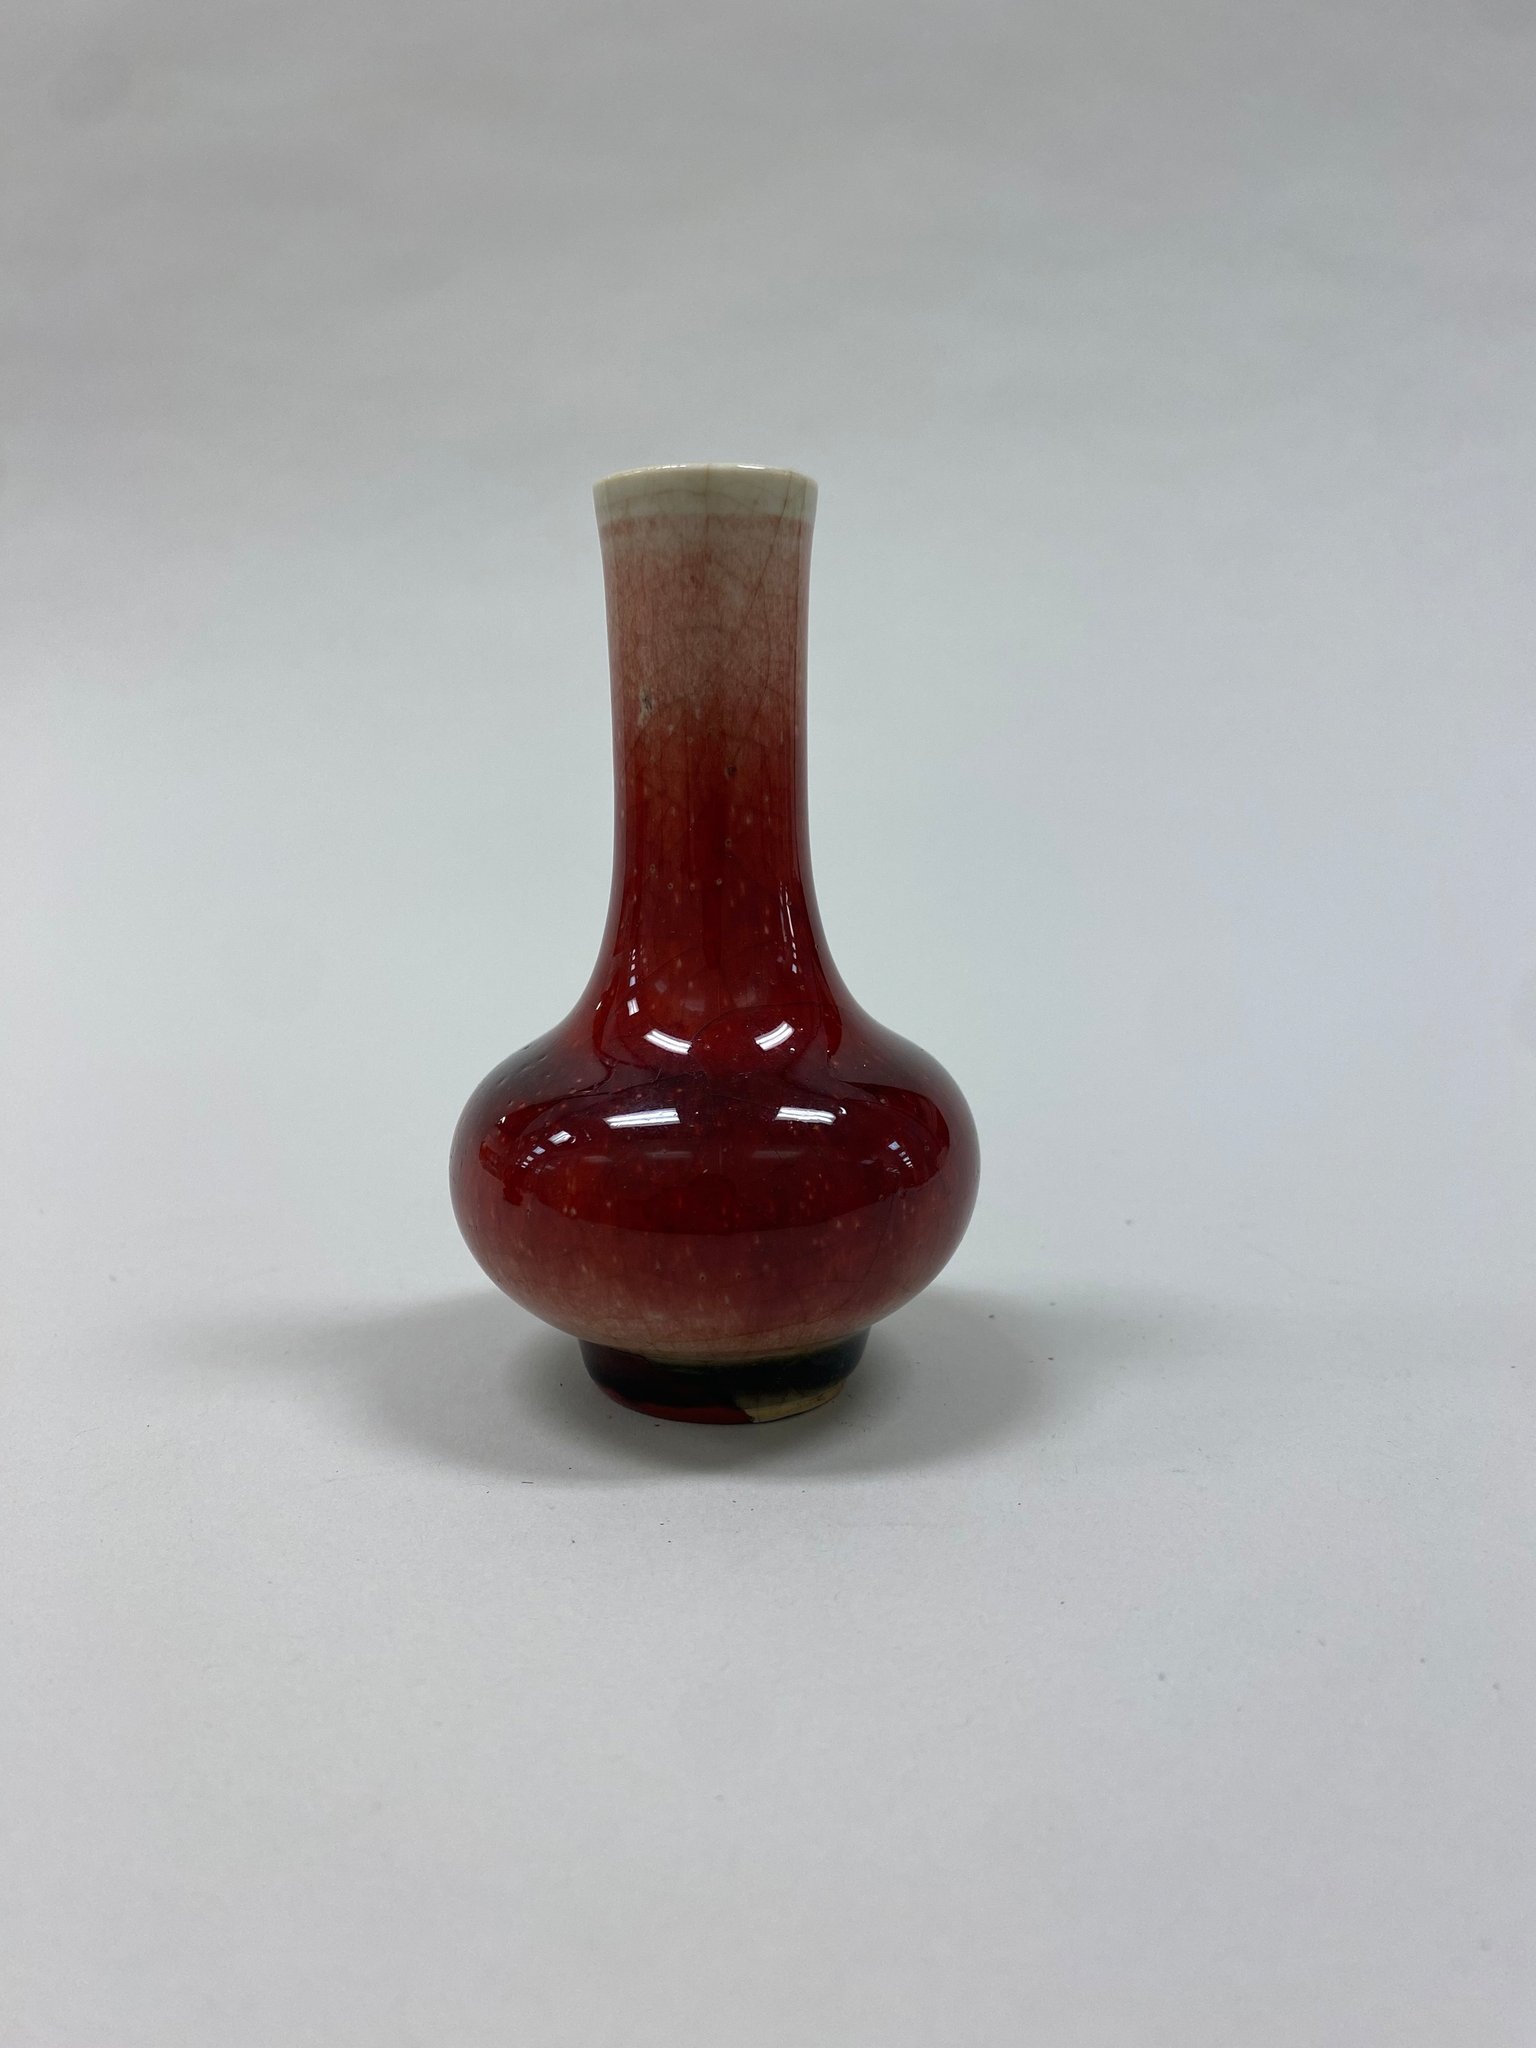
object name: vase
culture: chinese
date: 1667-1733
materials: glaze, porcelain